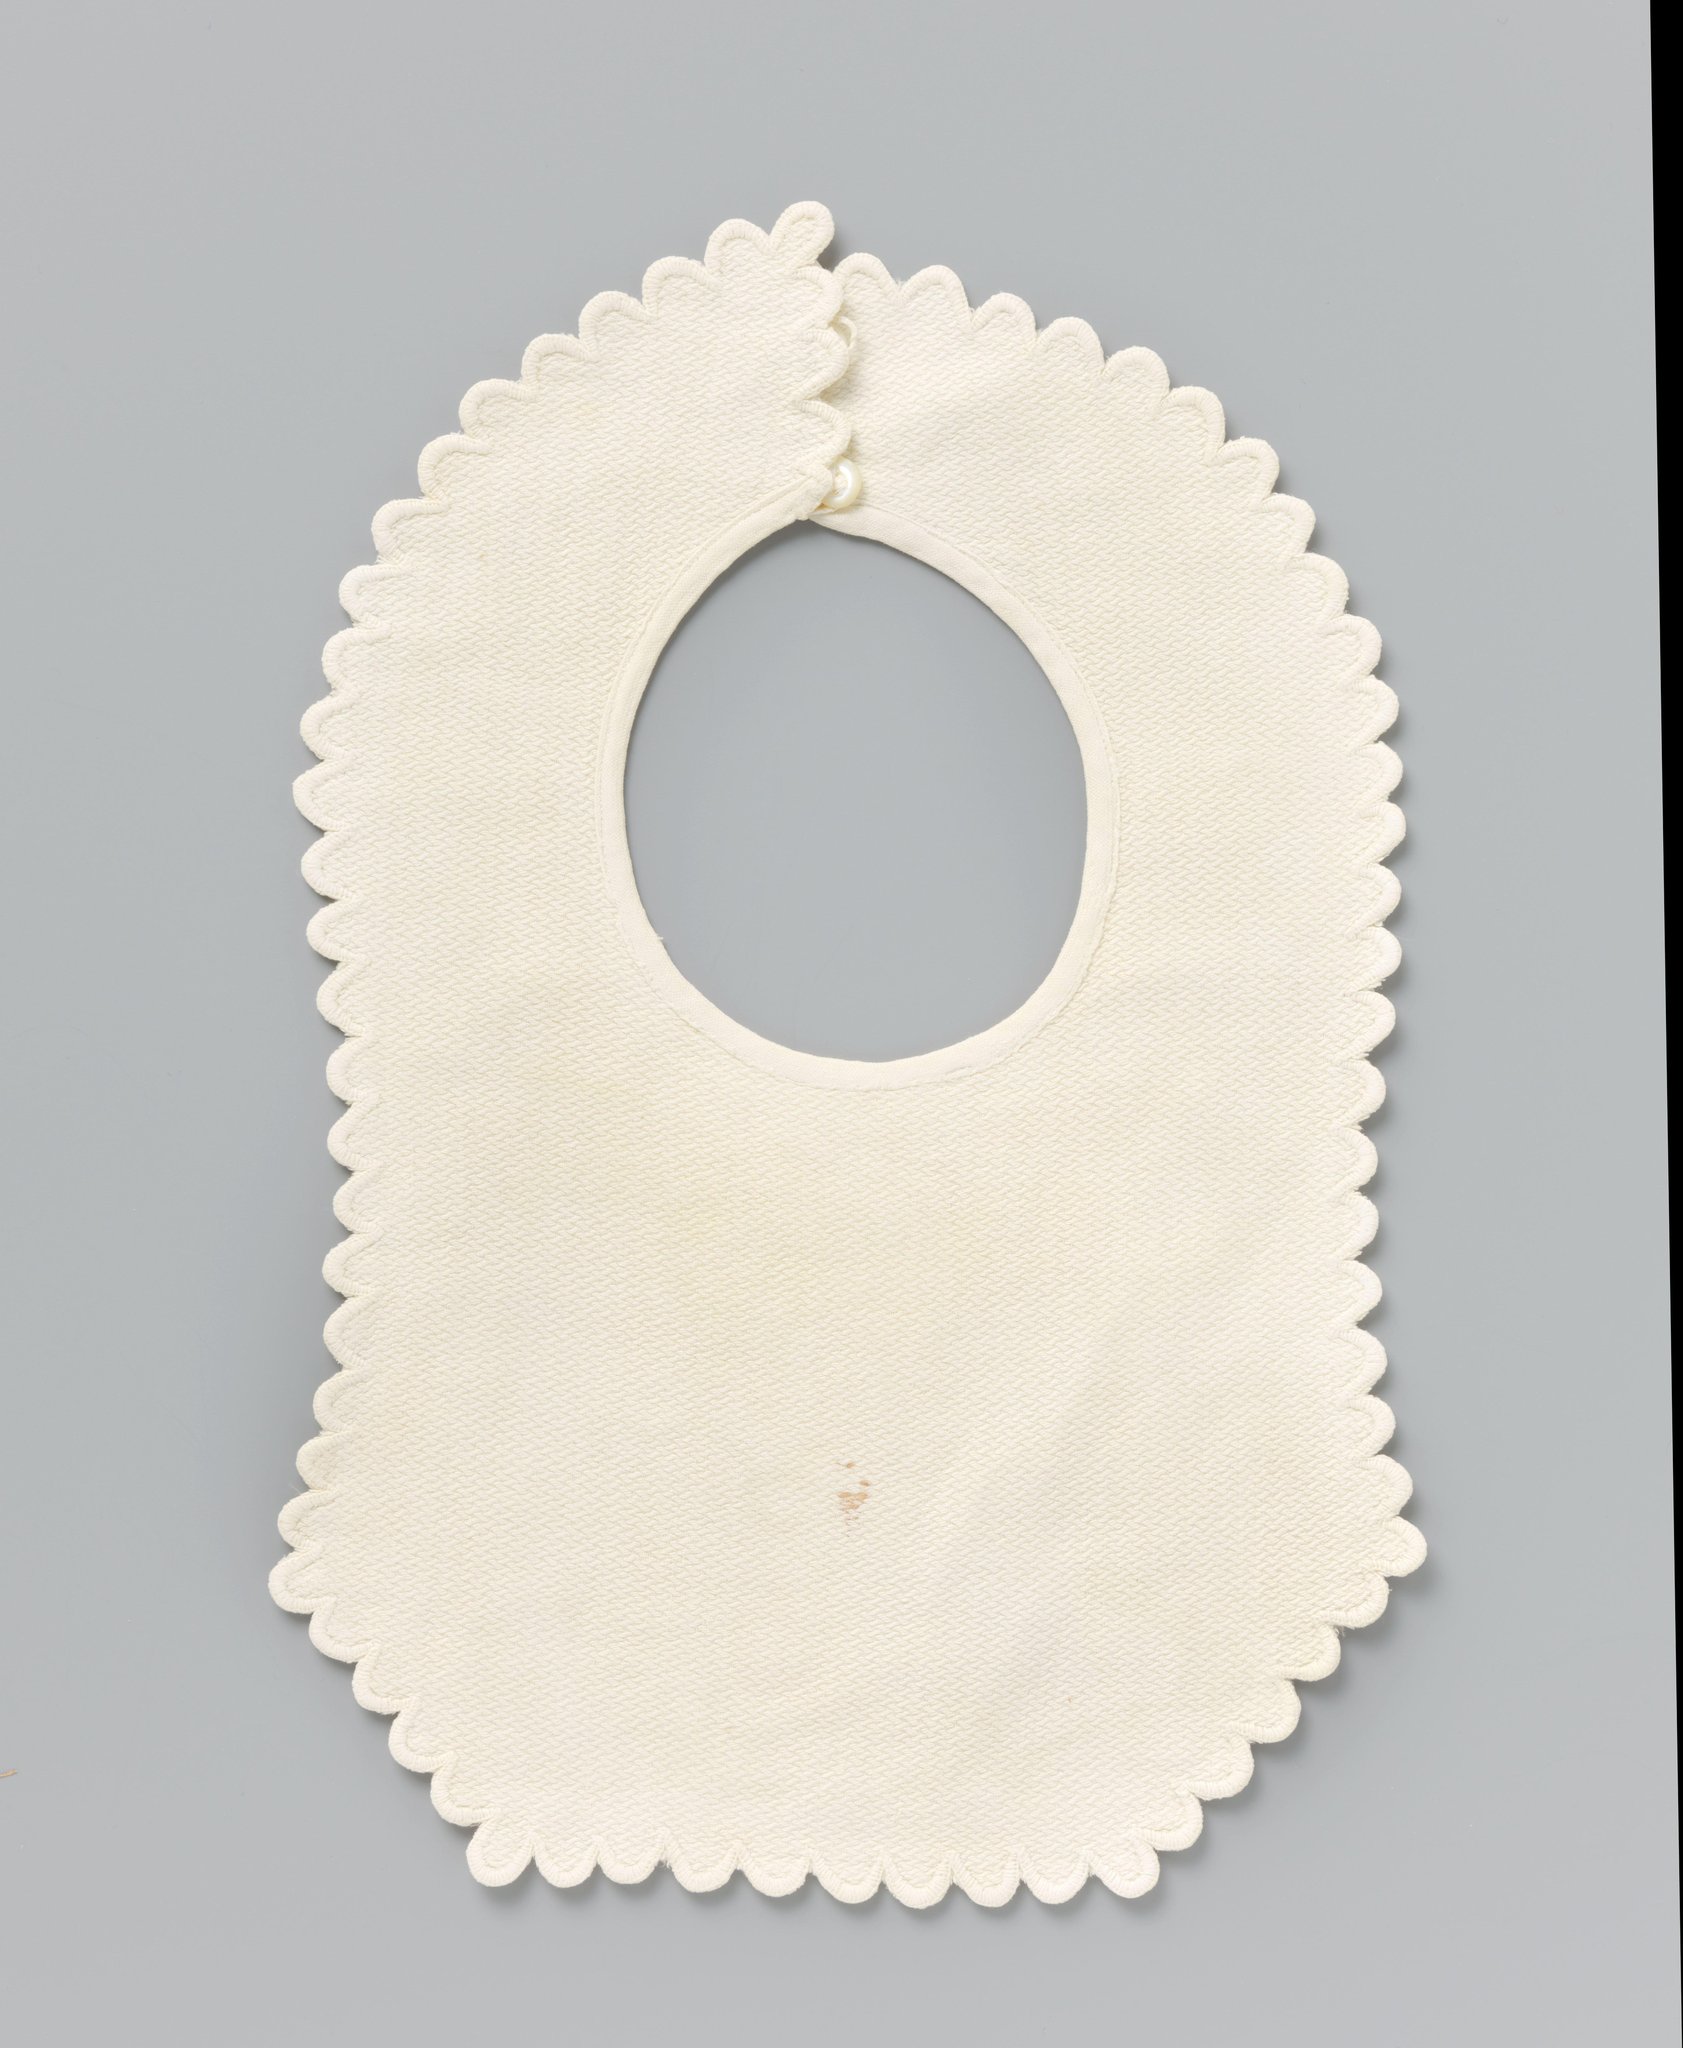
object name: bib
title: Slab van wit katoen (?) met ingeweven golfmotief in reliëf en geschulpte gefestonneerde rand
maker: Anonymous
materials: cotton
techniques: festooning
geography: europe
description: Slab van wit katoen (?) met ingeweven golfmotief in reliëf en geschulpte gefestonneerde rand.